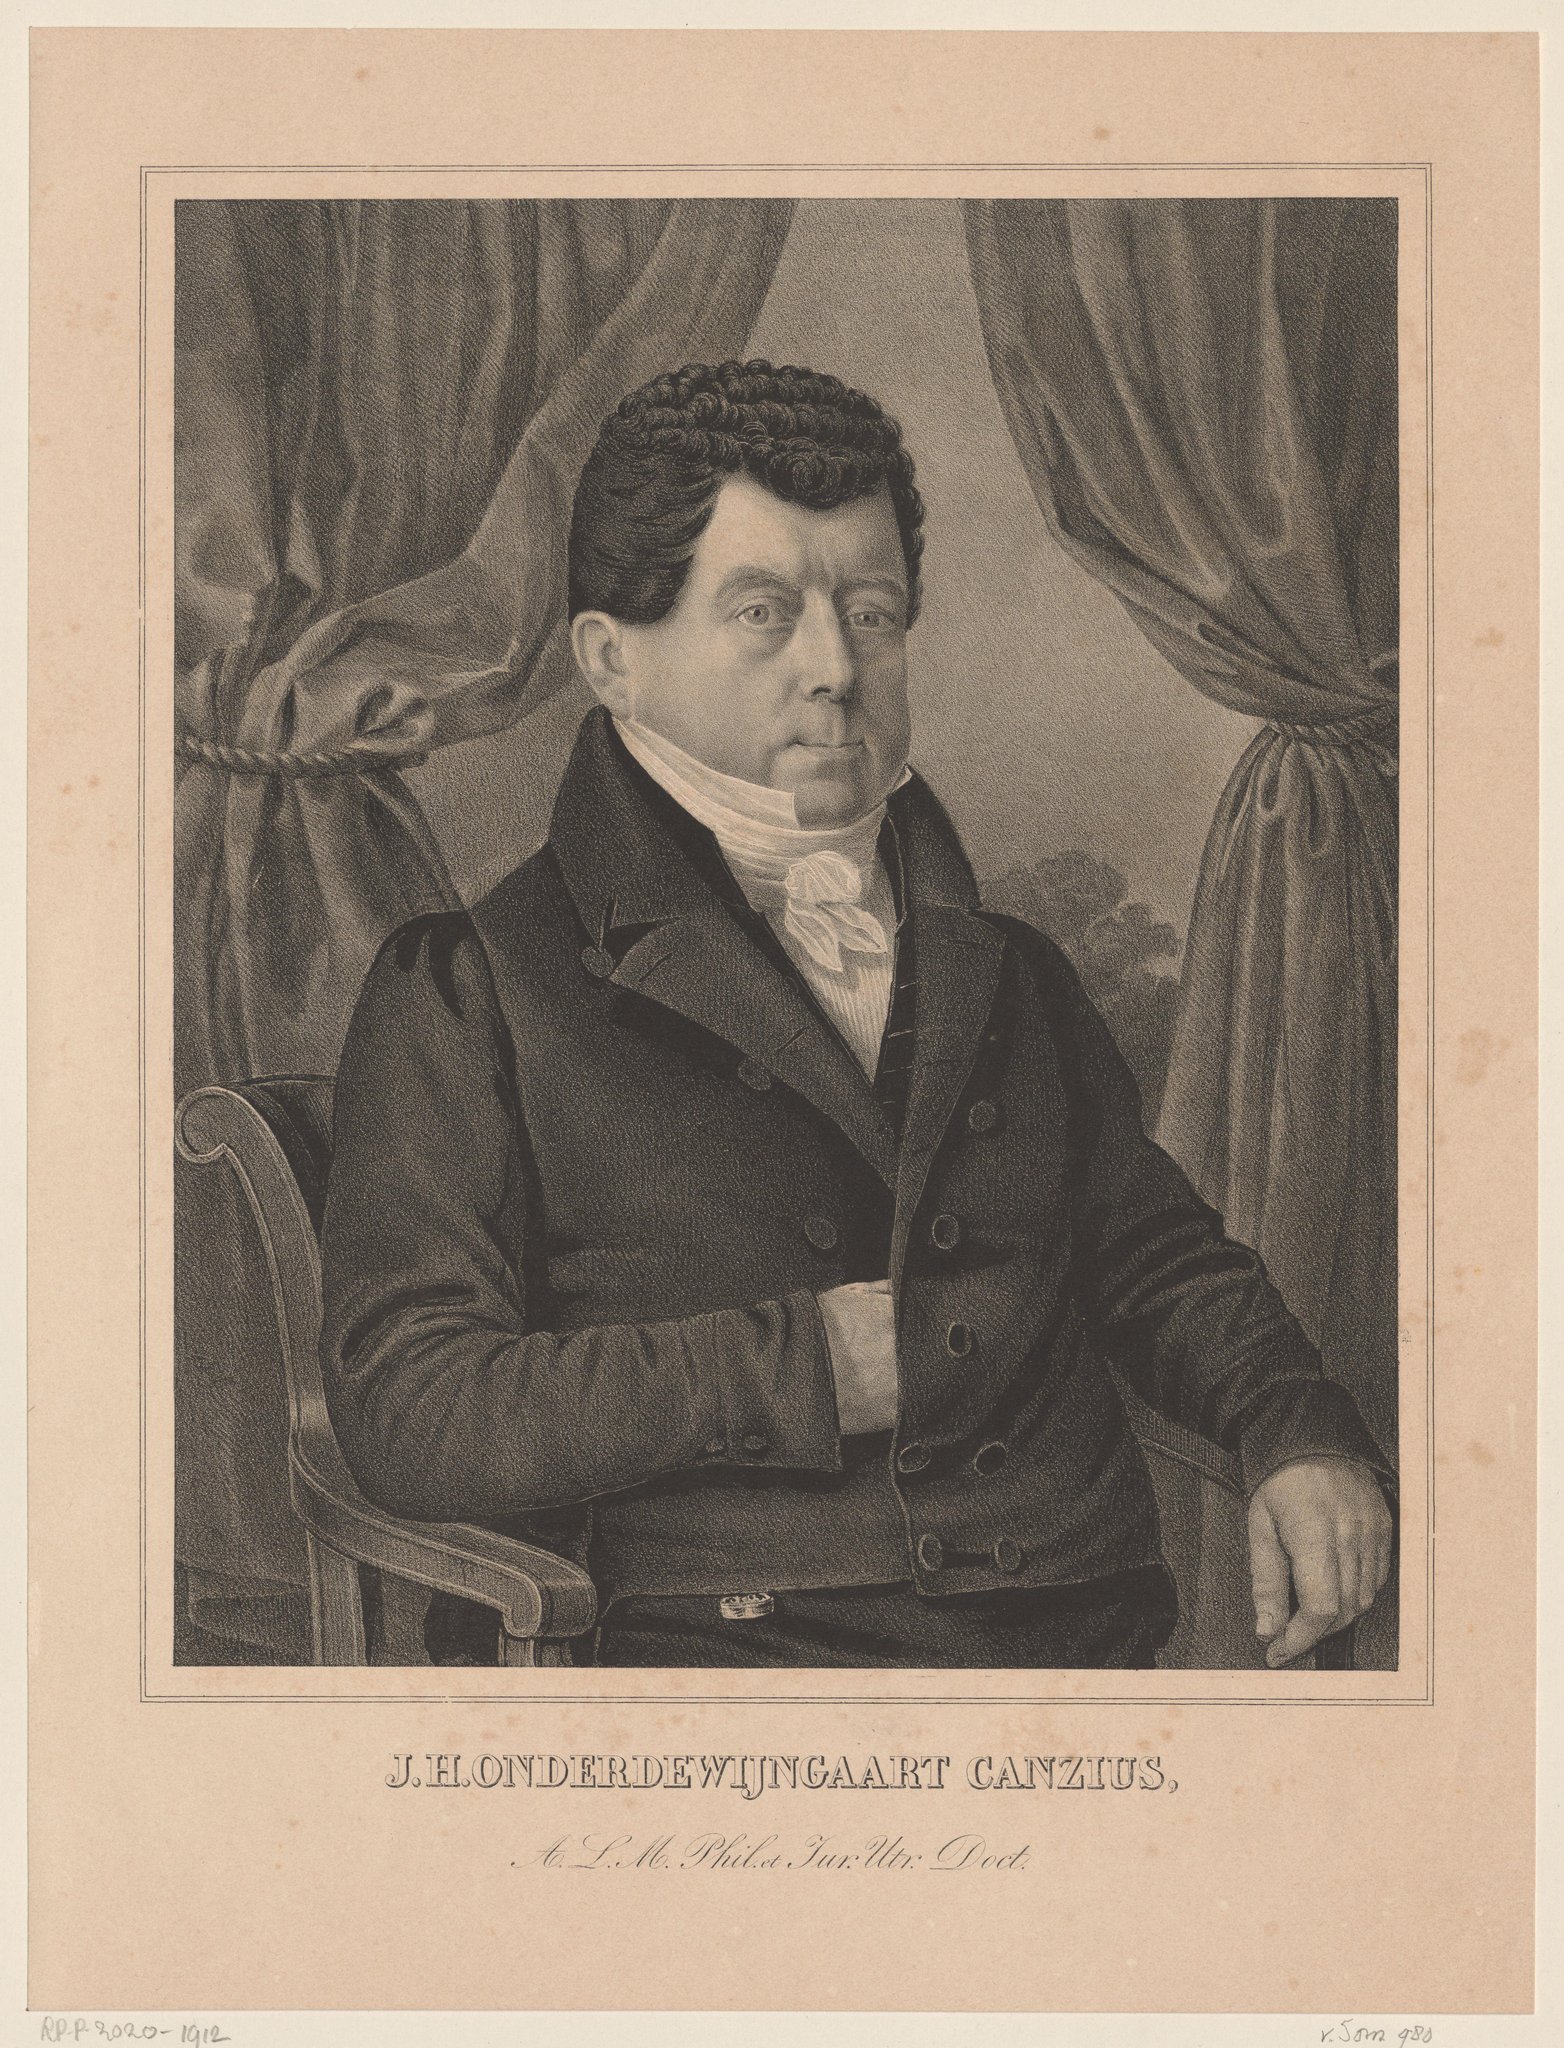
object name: print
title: Portret van Jacob Hendrik Onderdewijngaart Canzius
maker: Anonymous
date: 1795-1858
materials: paper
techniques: lithograph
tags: jacob hendrik onderdewijngaart canzius, historical persons